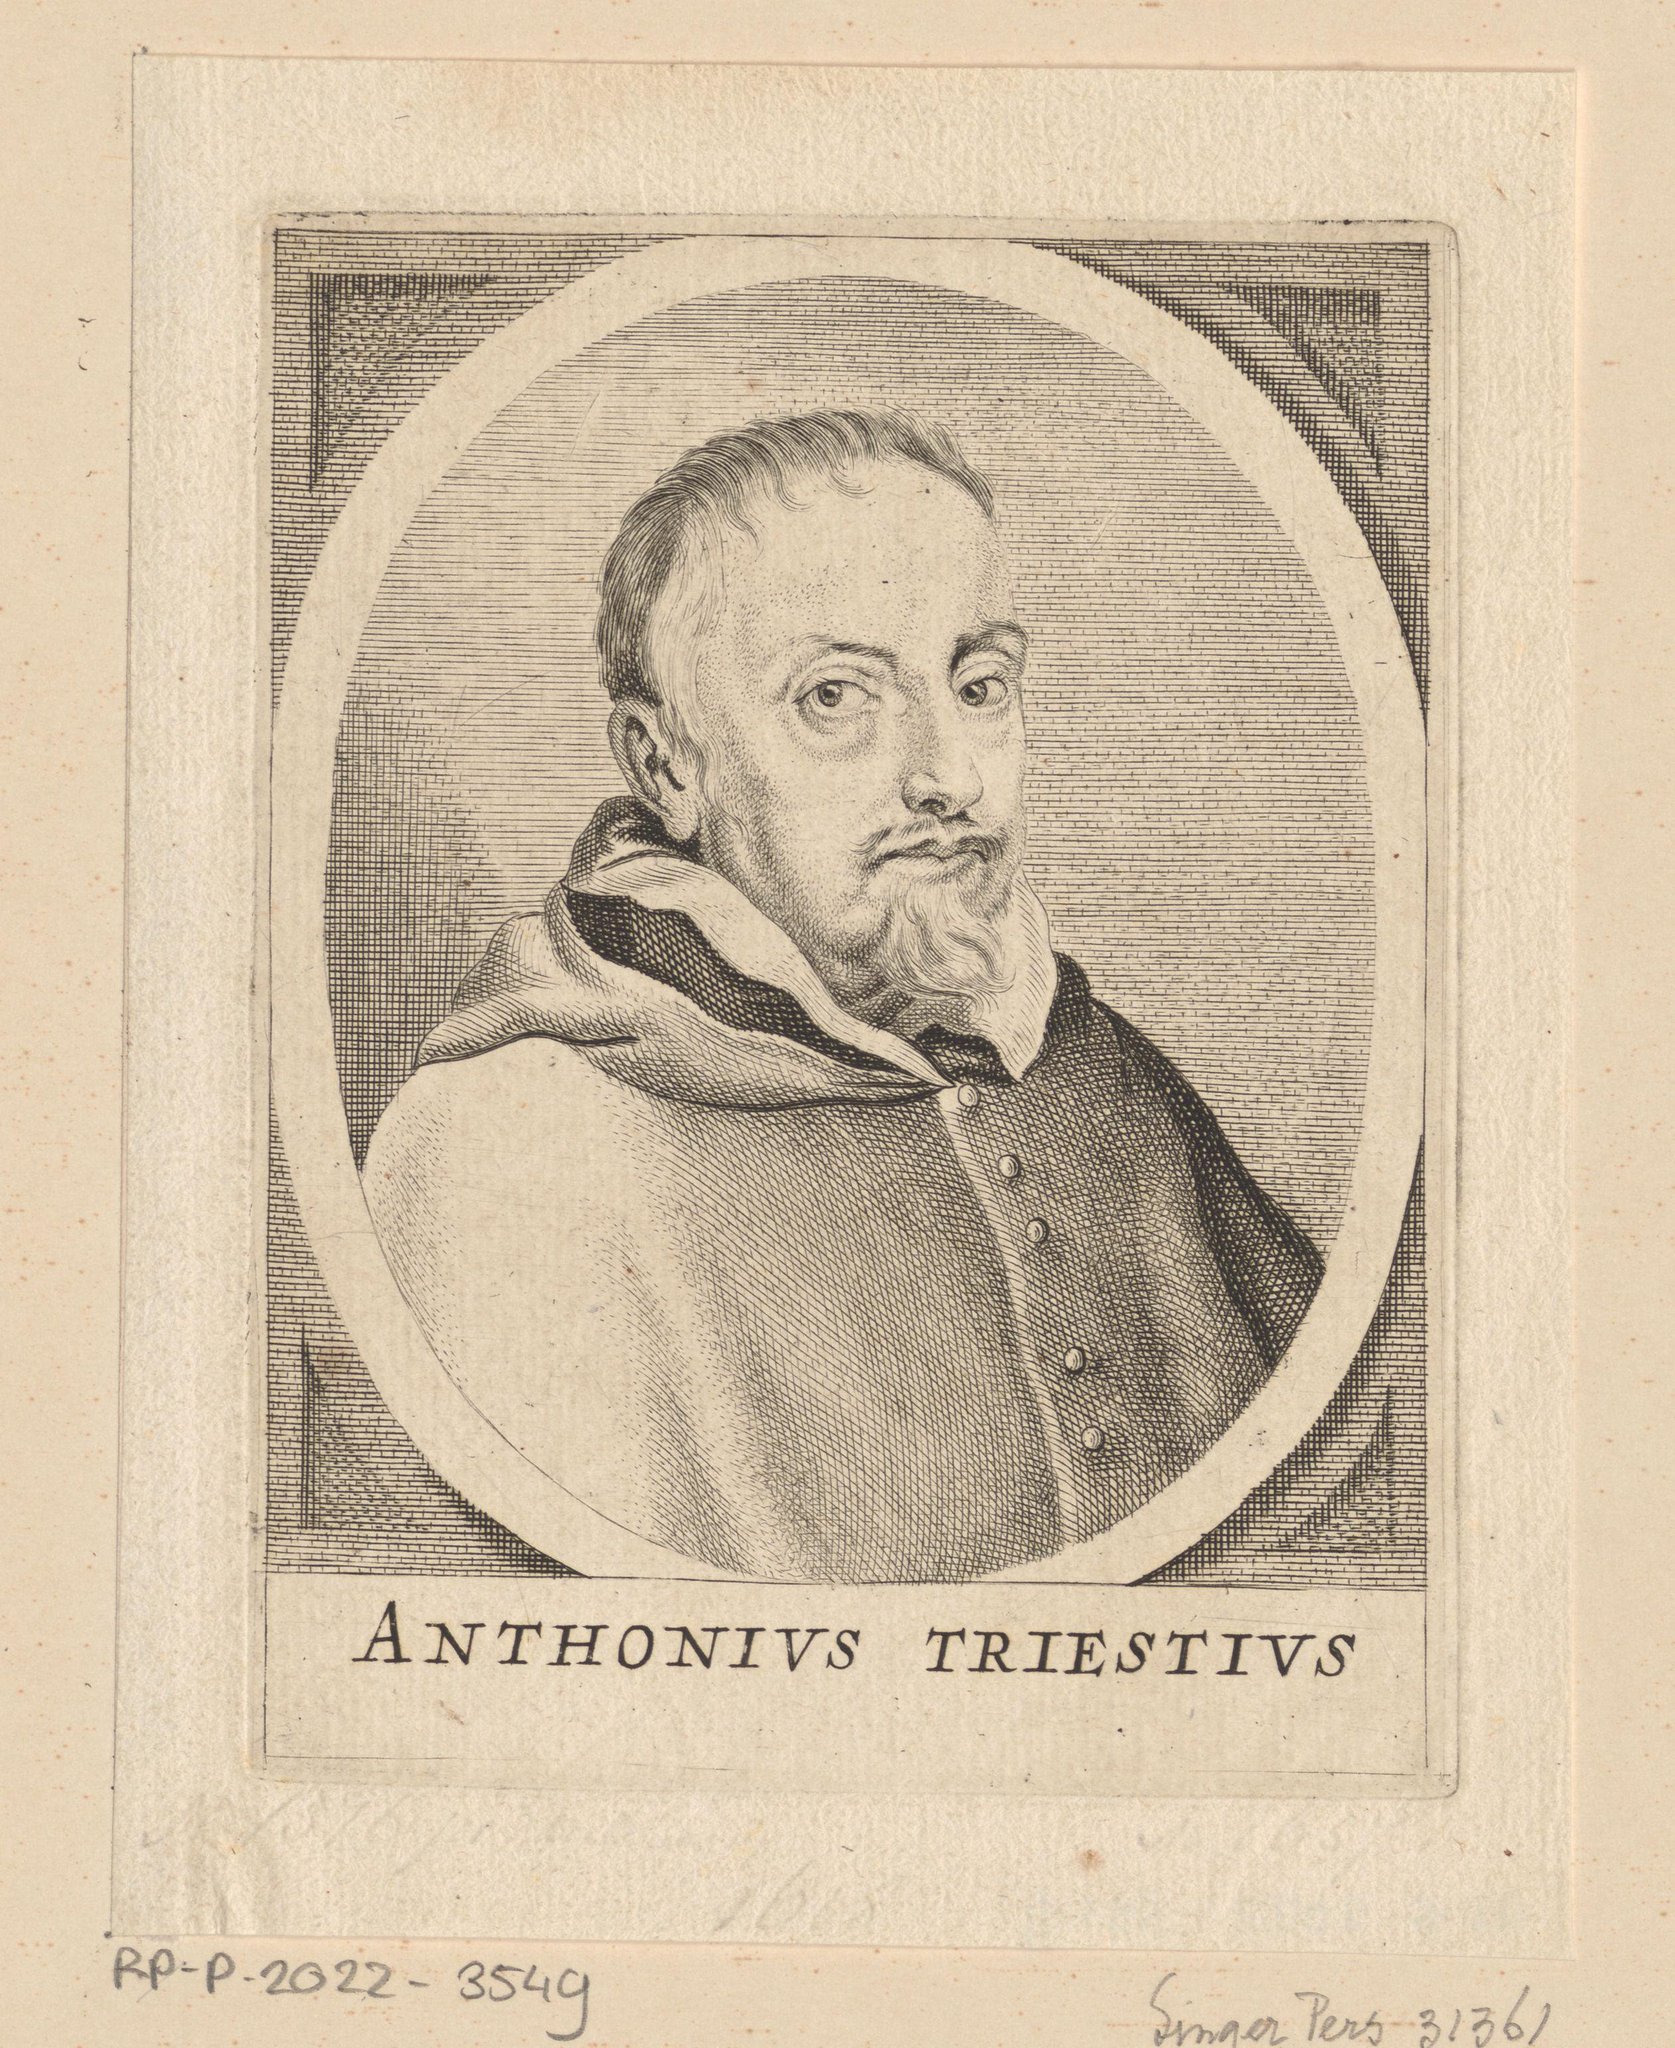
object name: print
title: Portret van Antonius Triest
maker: Anonymous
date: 1700-1799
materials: paper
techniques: engraving, etching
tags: antonius triest, archbishop, bishop, etc. (roman catholic), historical persons